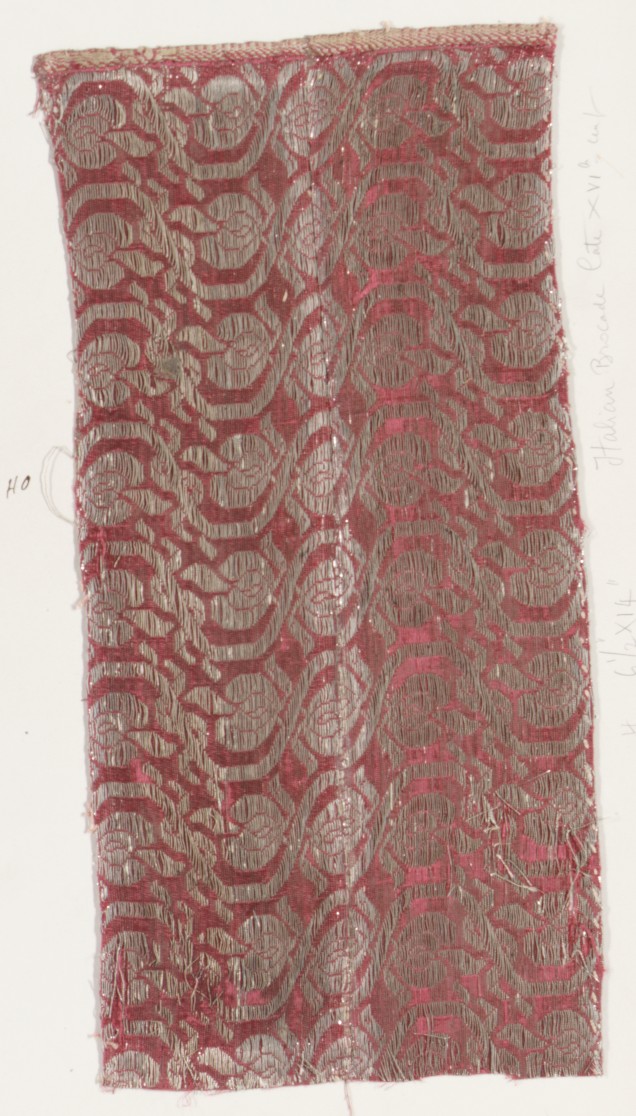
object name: fragment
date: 1501-1600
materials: metal thread, silk